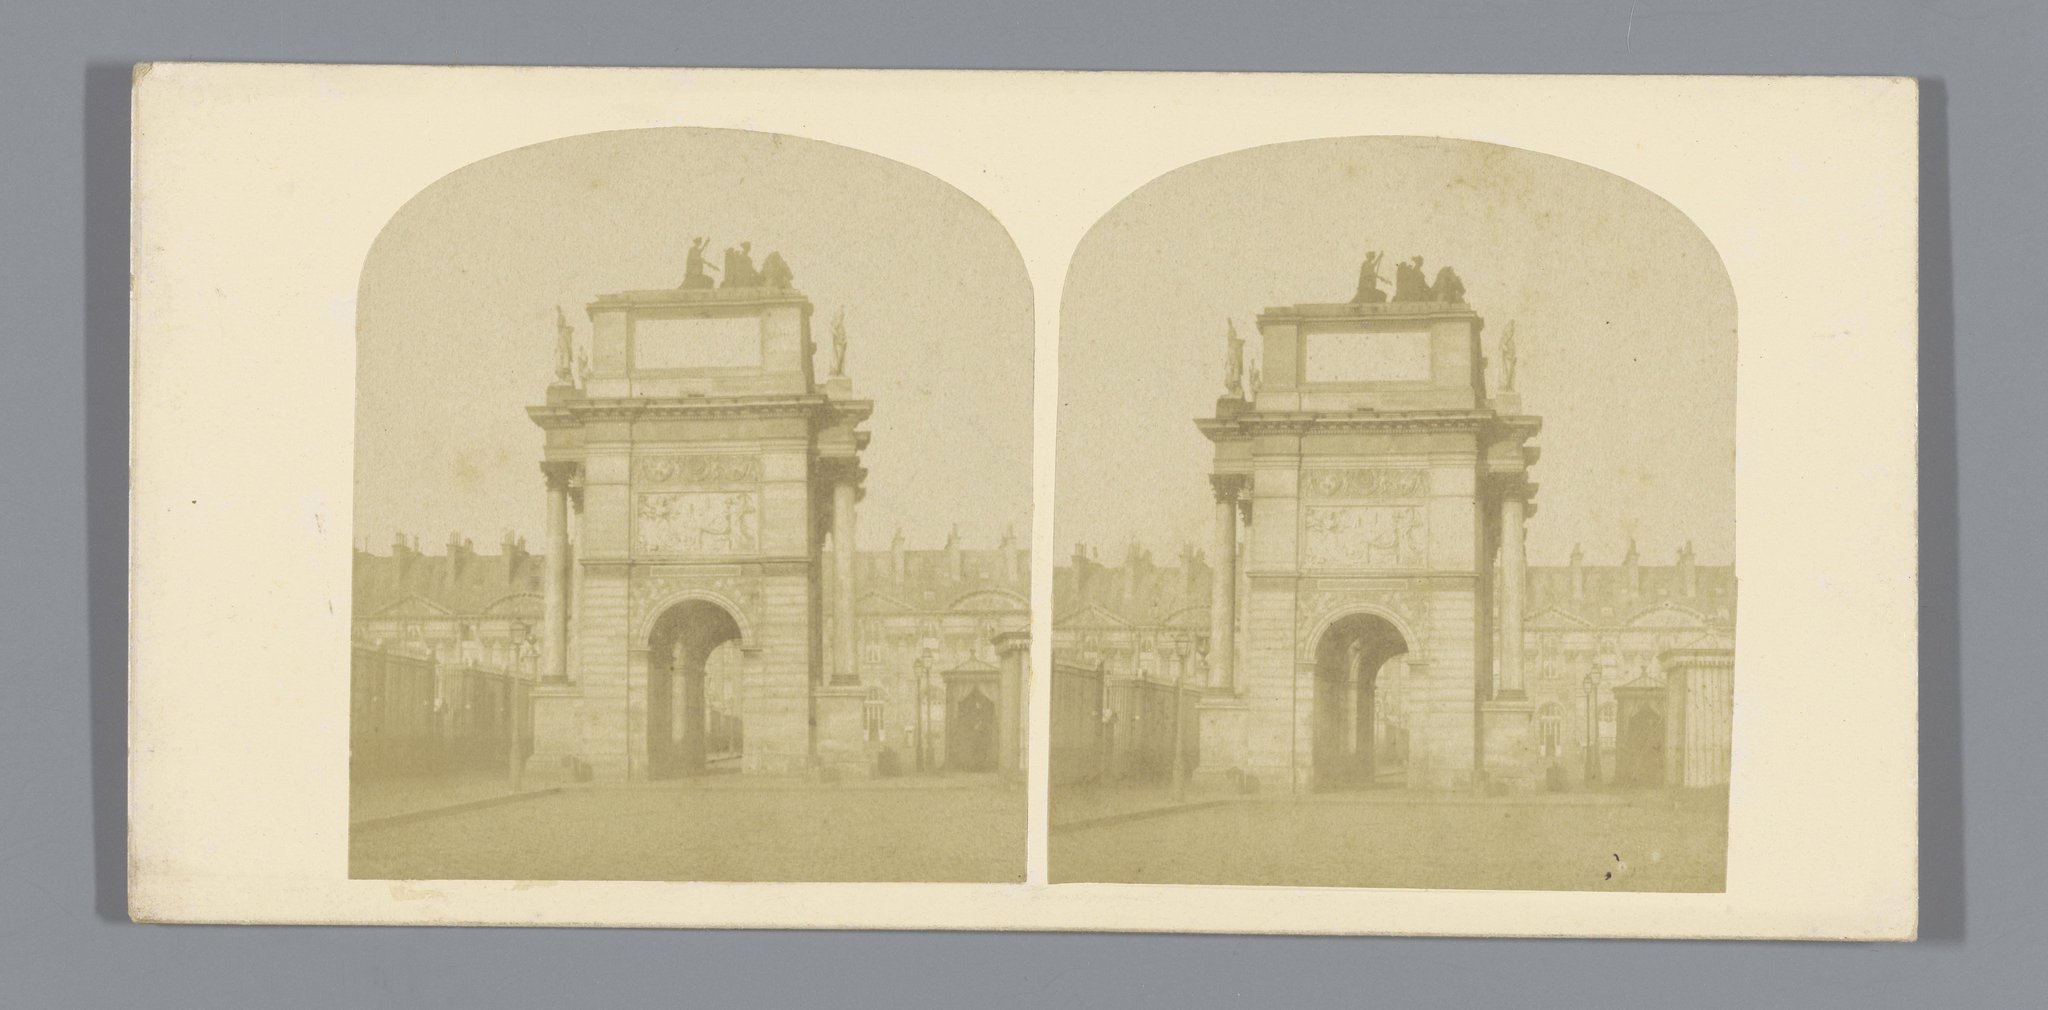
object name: stereograph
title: Arc de Triomphe du Carrousel te Parijs, vanaf de zijkant gezien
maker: Anonymous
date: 1860-1870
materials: cardboard, photographic support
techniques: albumen print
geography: place du carrousel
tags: triumphal arch